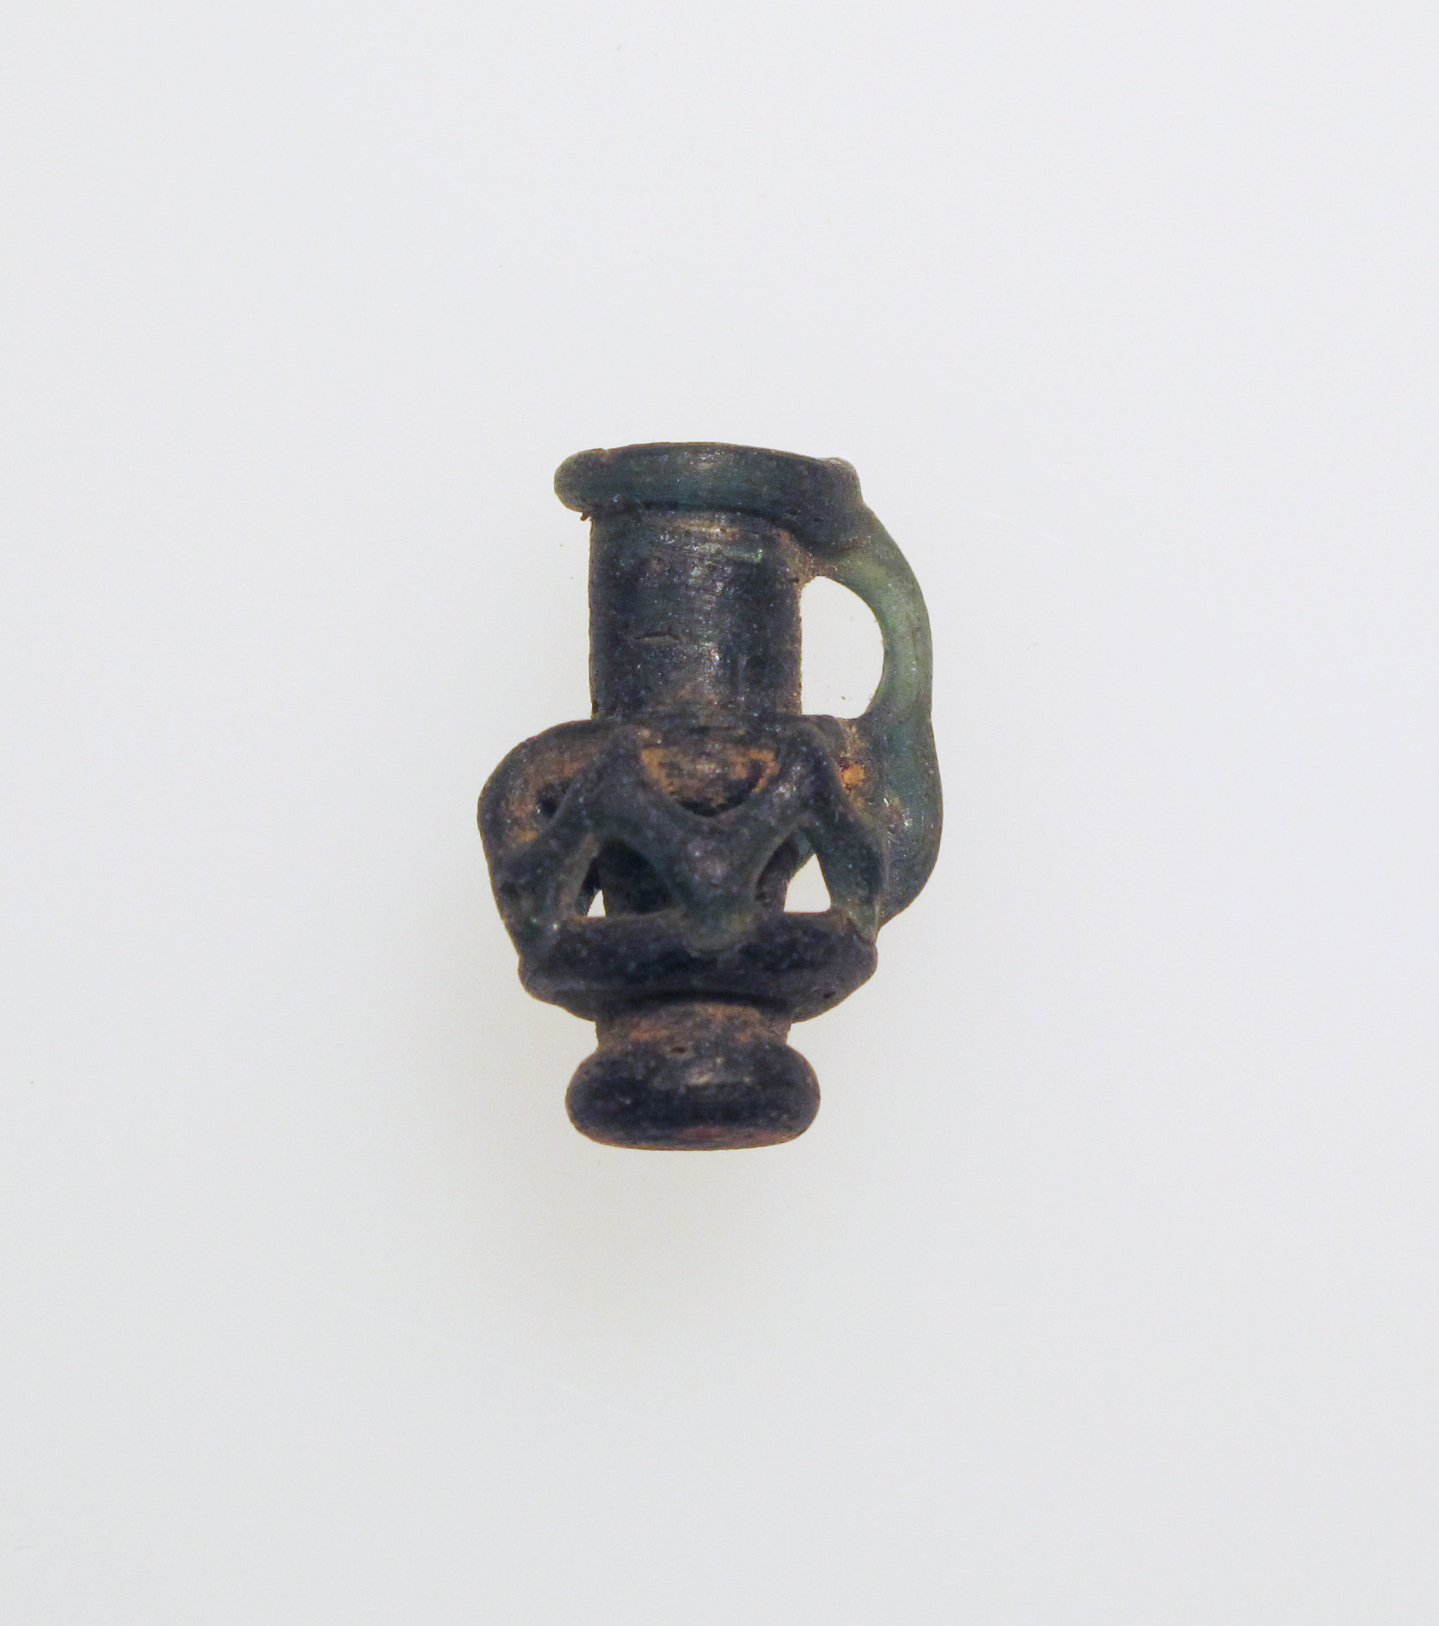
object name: pendant in the form of a vase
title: Glass pendant in the form of a vase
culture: roman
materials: glass